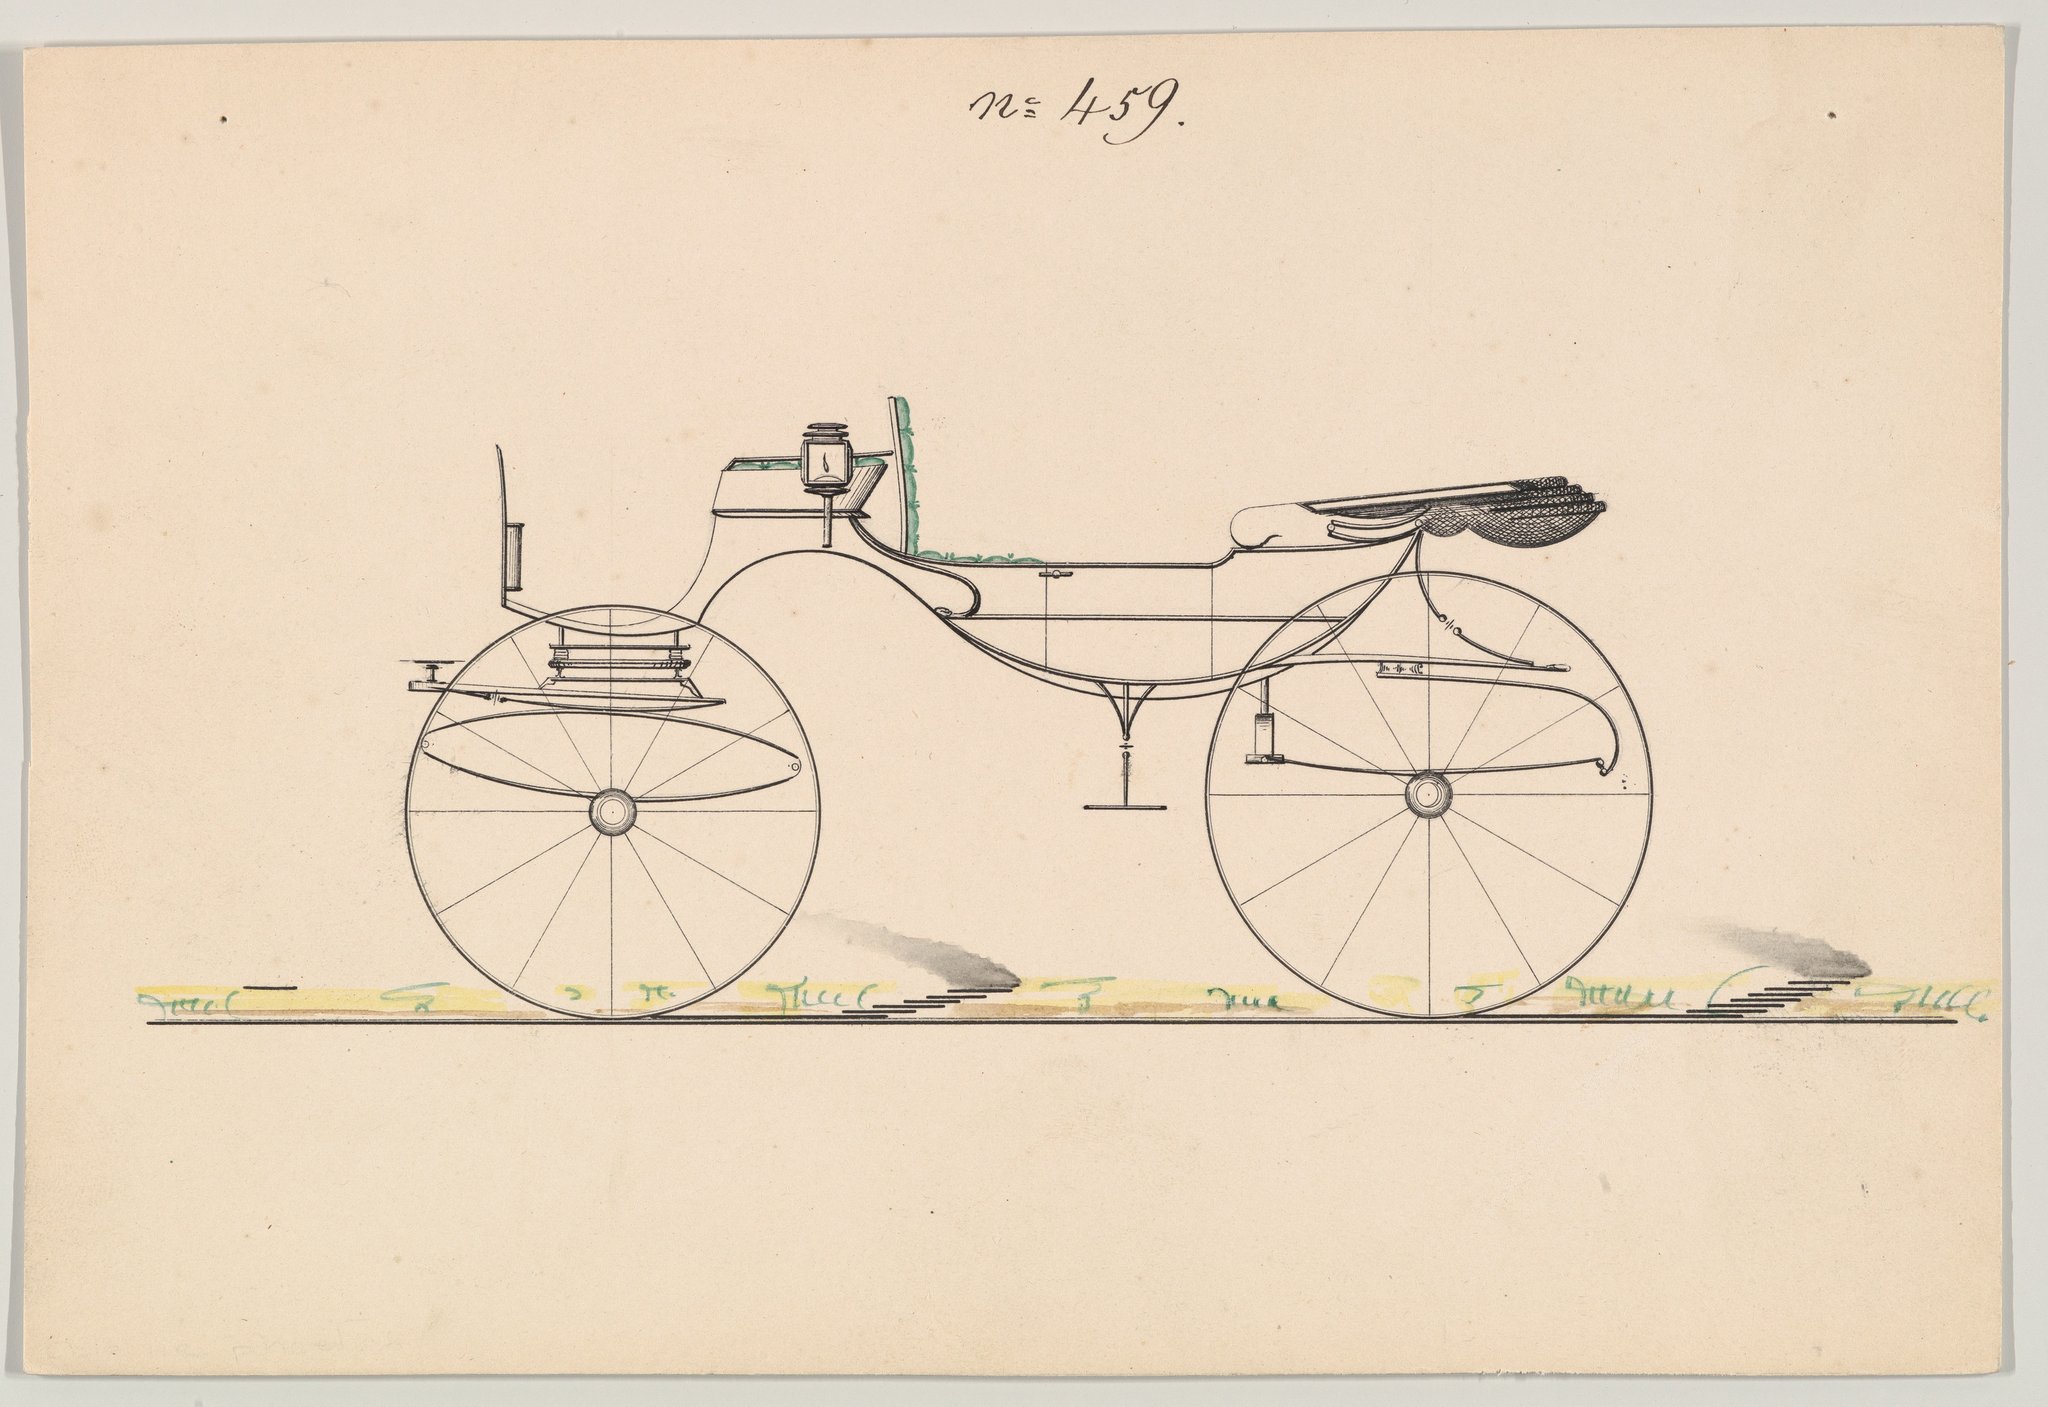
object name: drawing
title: Design for Vis-à-vis/ Barouche, no. 459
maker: brewster & co.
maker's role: manufacturer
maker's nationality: american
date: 1850-1870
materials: ink, watercolor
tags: carriages